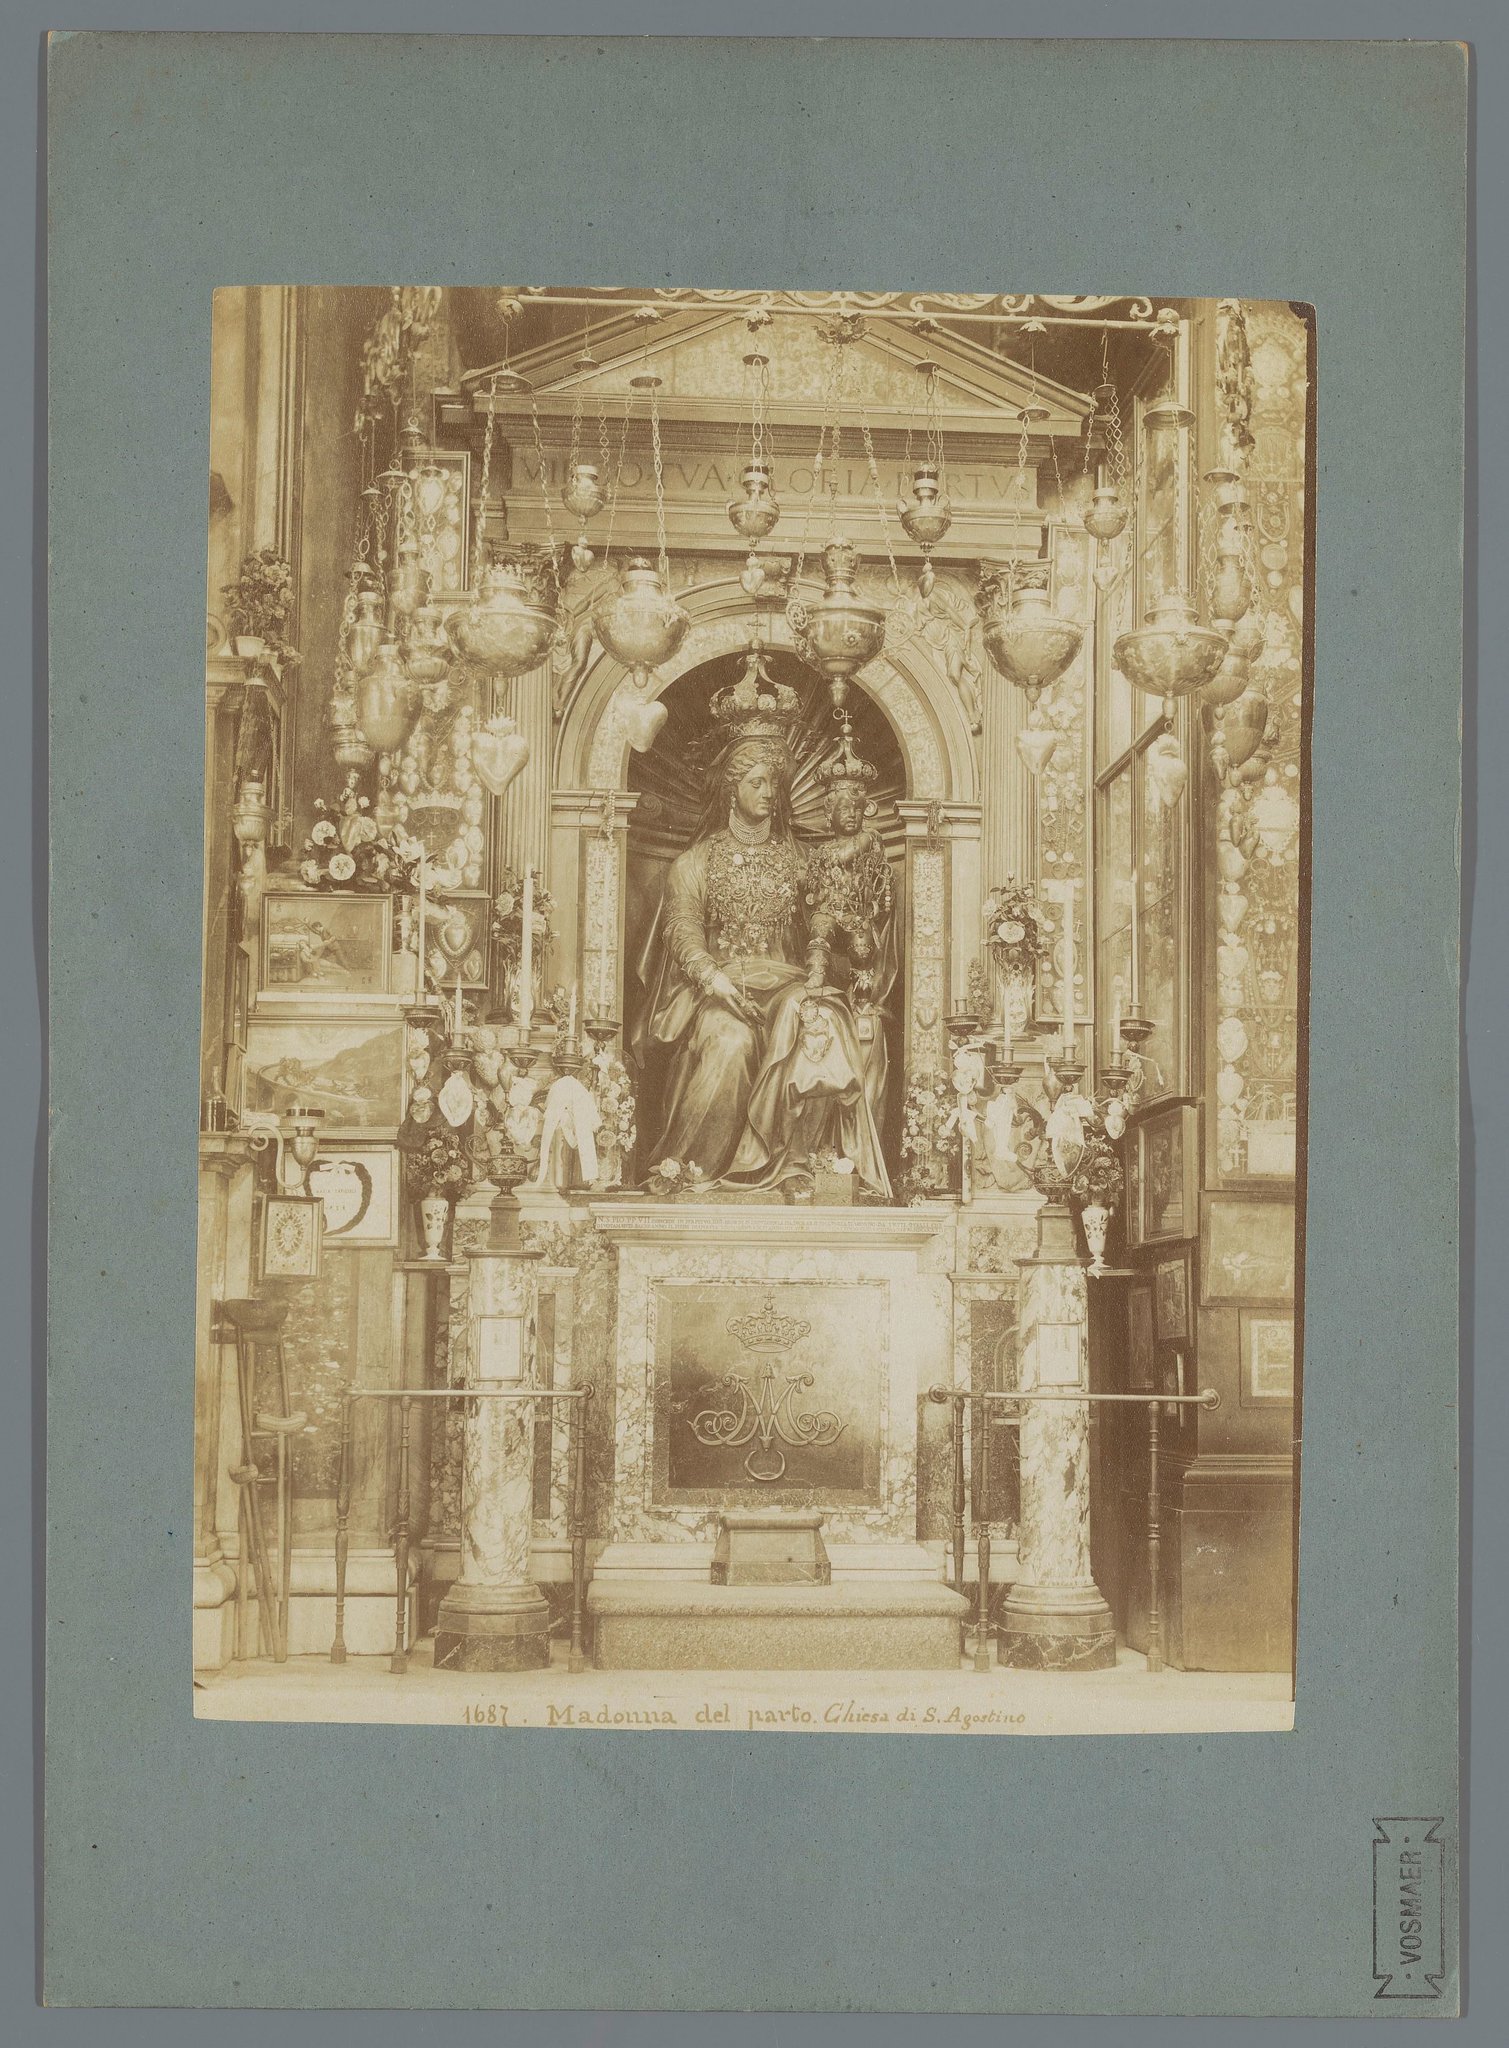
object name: ansichtkaart, prentbriefkaart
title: La mere de nos soldats. De moeder onzen soldaten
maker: dl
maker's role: fotograaf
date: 1914-1918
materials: photographic support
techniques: gelatin silver print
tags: laeken